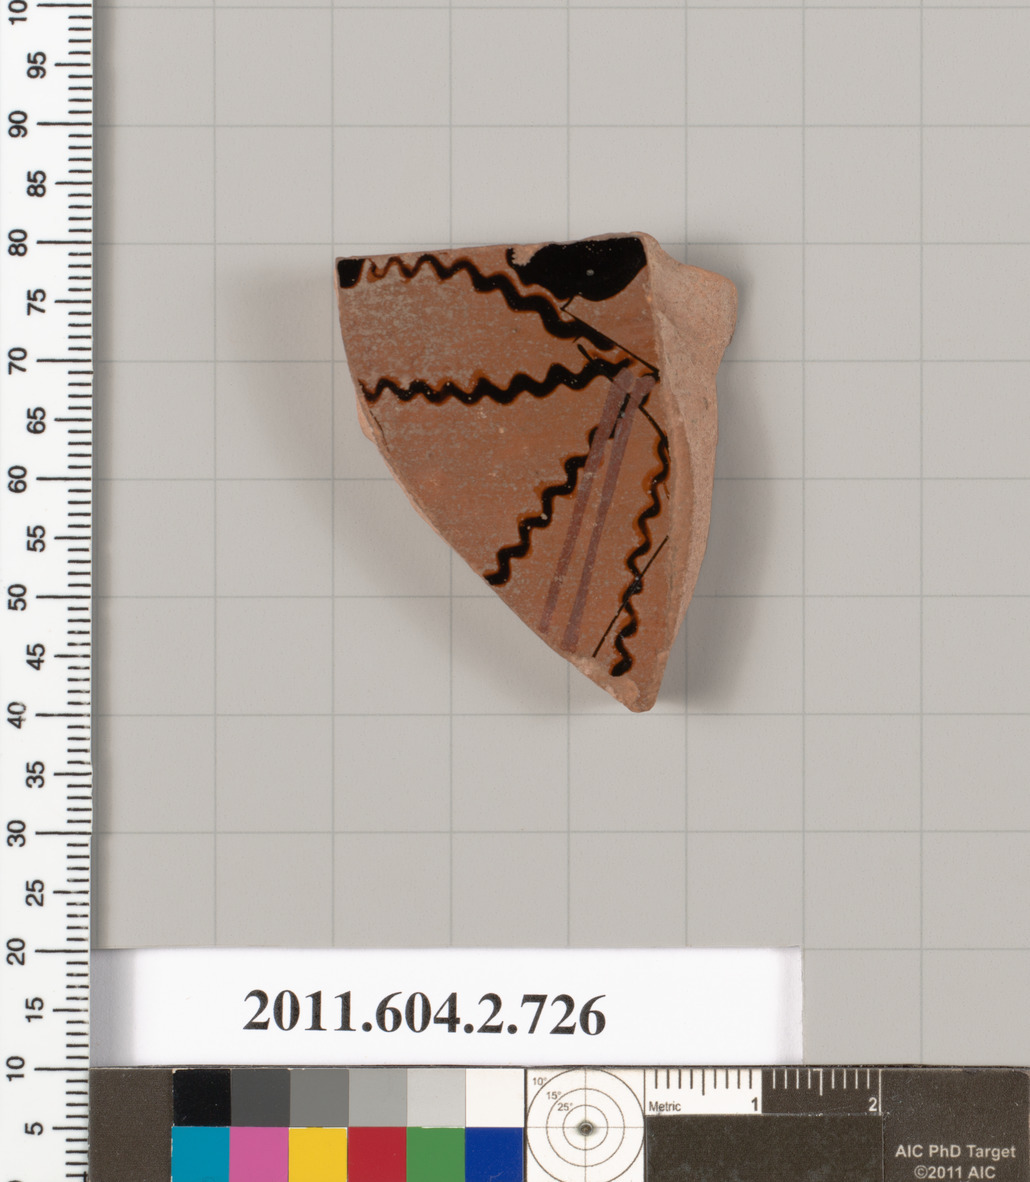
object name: calyx krater fragment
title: Terracotta fragment of a calyx-krater (bowl for mixing wine and water)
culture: greek, attic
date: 467-435 BCE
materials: terracotta